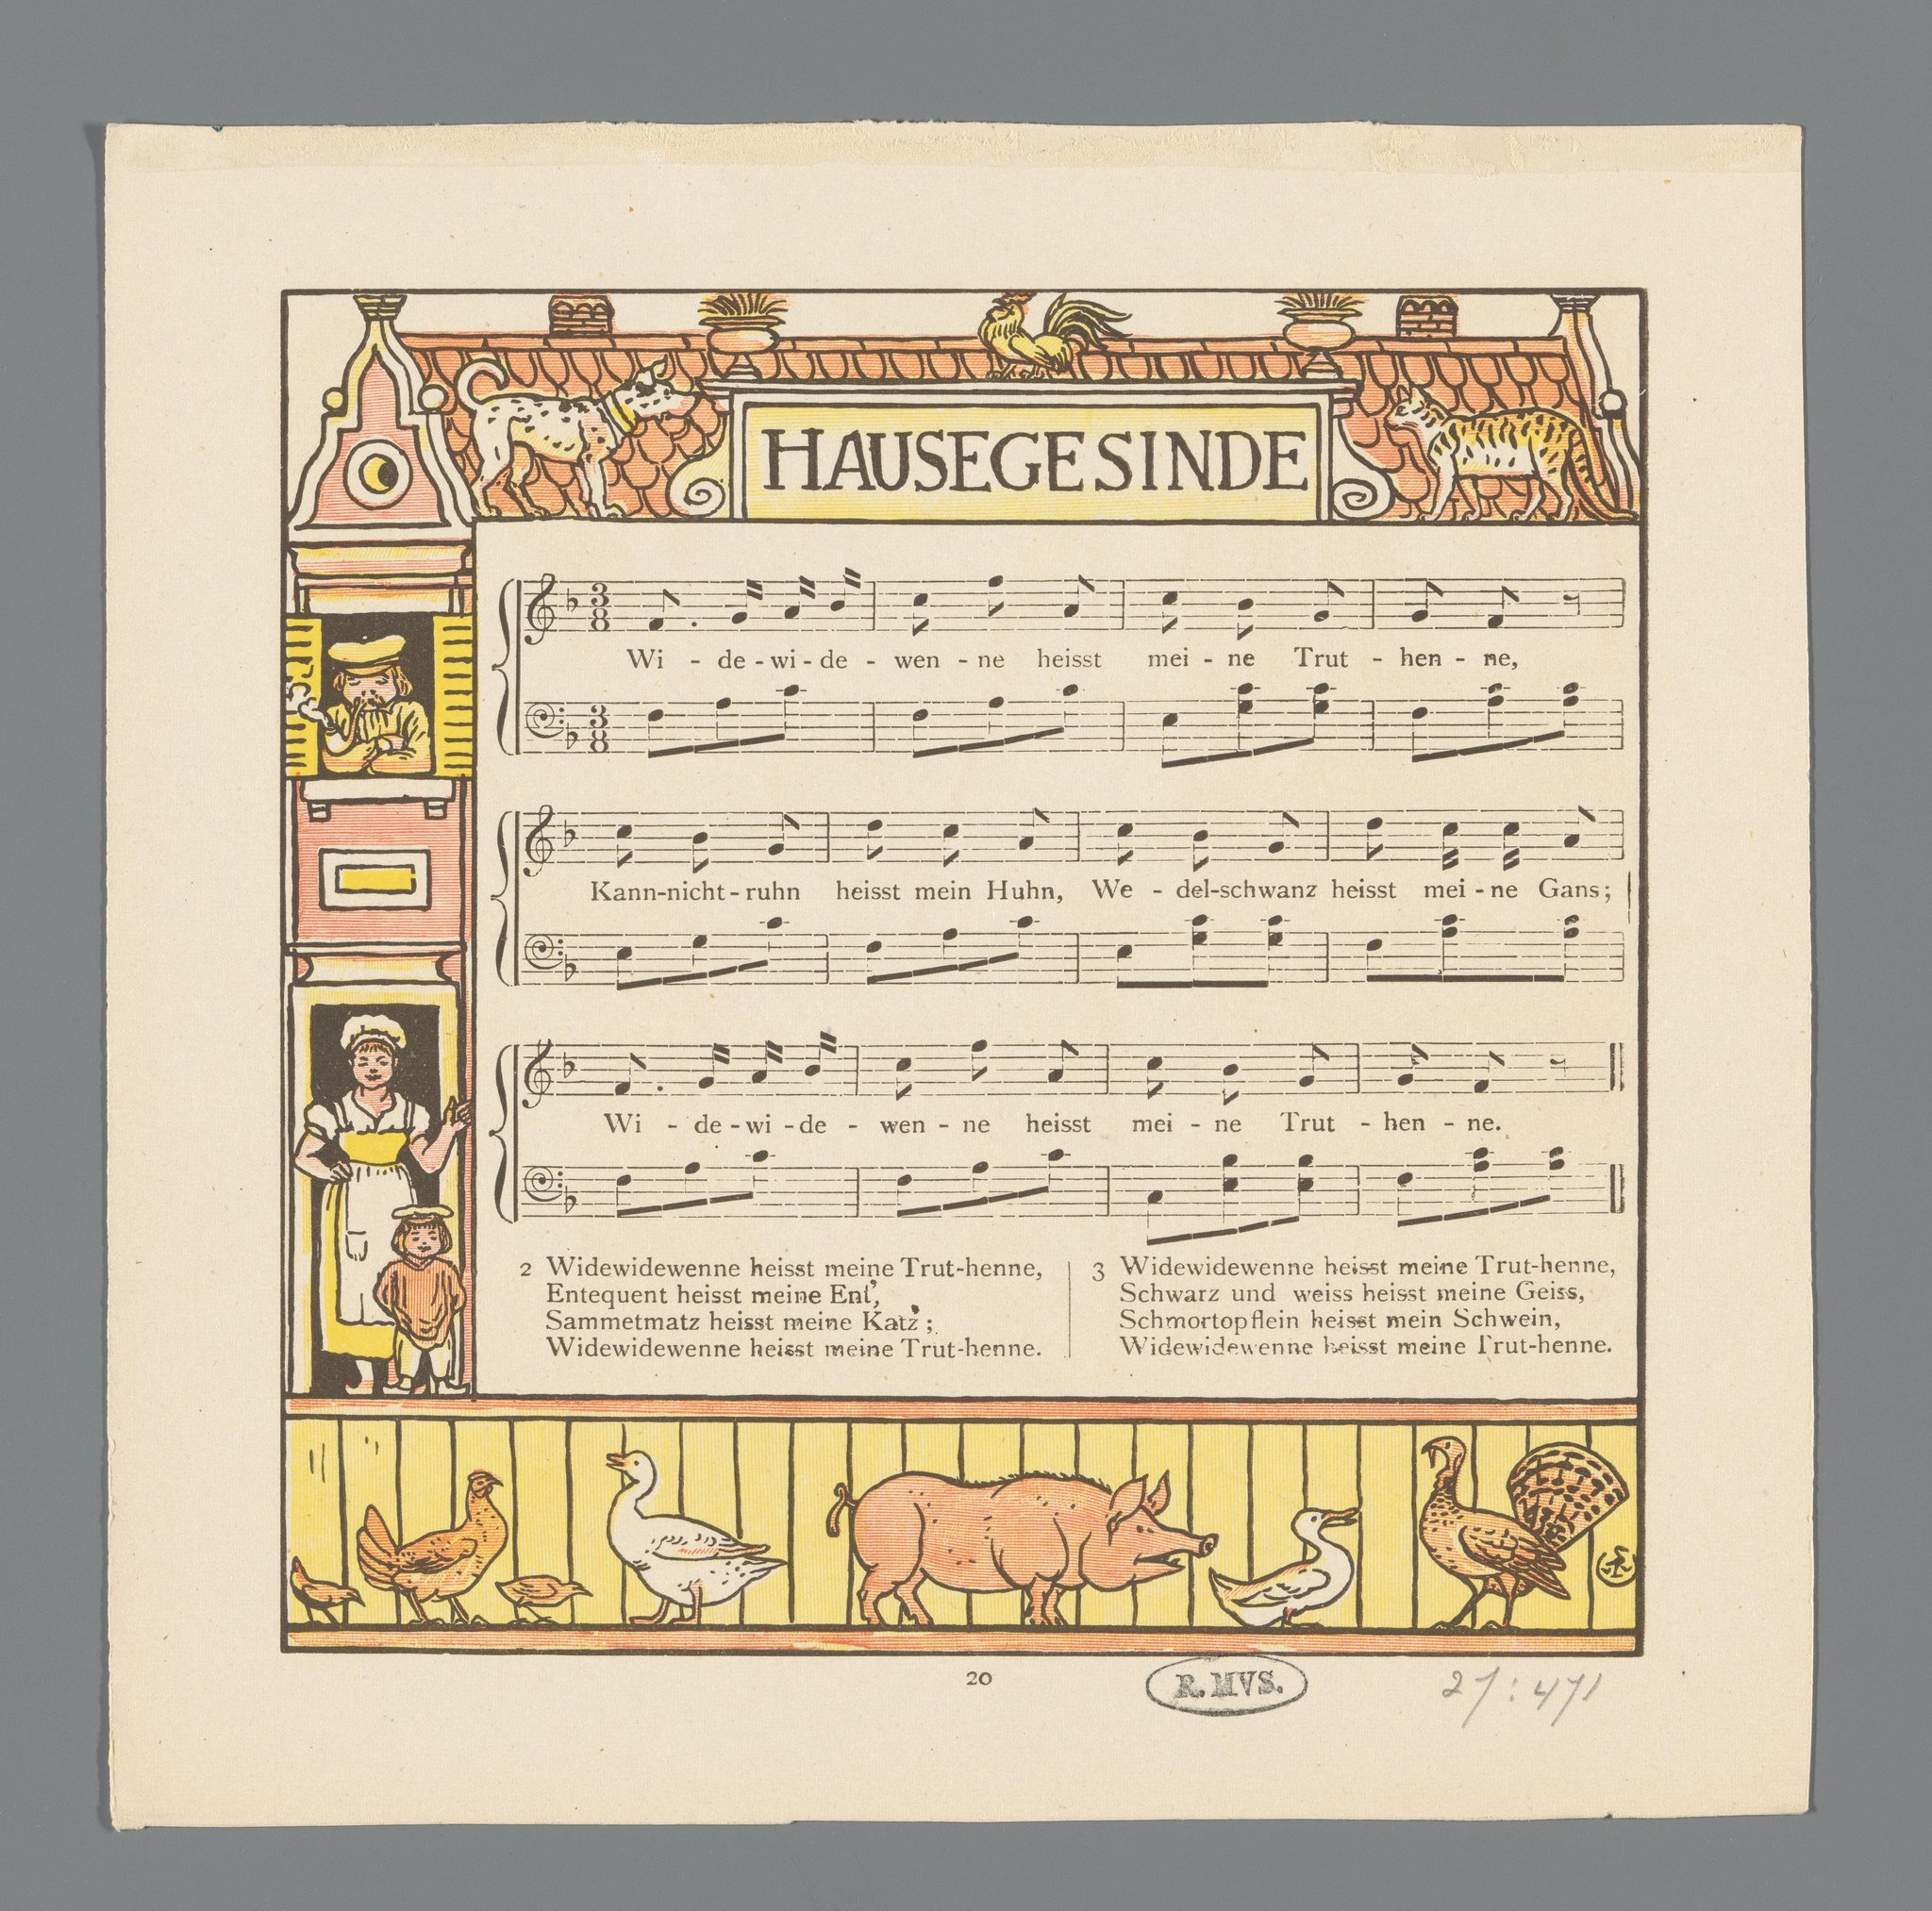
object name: sheet music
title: Hausegesinde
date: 1878-1927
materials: paper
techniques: wood engraving, letterpress printing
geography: london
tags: notation of music, cattle, civic architecture; edifices; dwellings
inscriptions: collector's mark: Lugt 2228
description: Prent uit: The baby's bouquet, a fresh bunch of old rhymes and tunes. Londen: Routledge & Sons, [1878]. Of een latere uitgave.